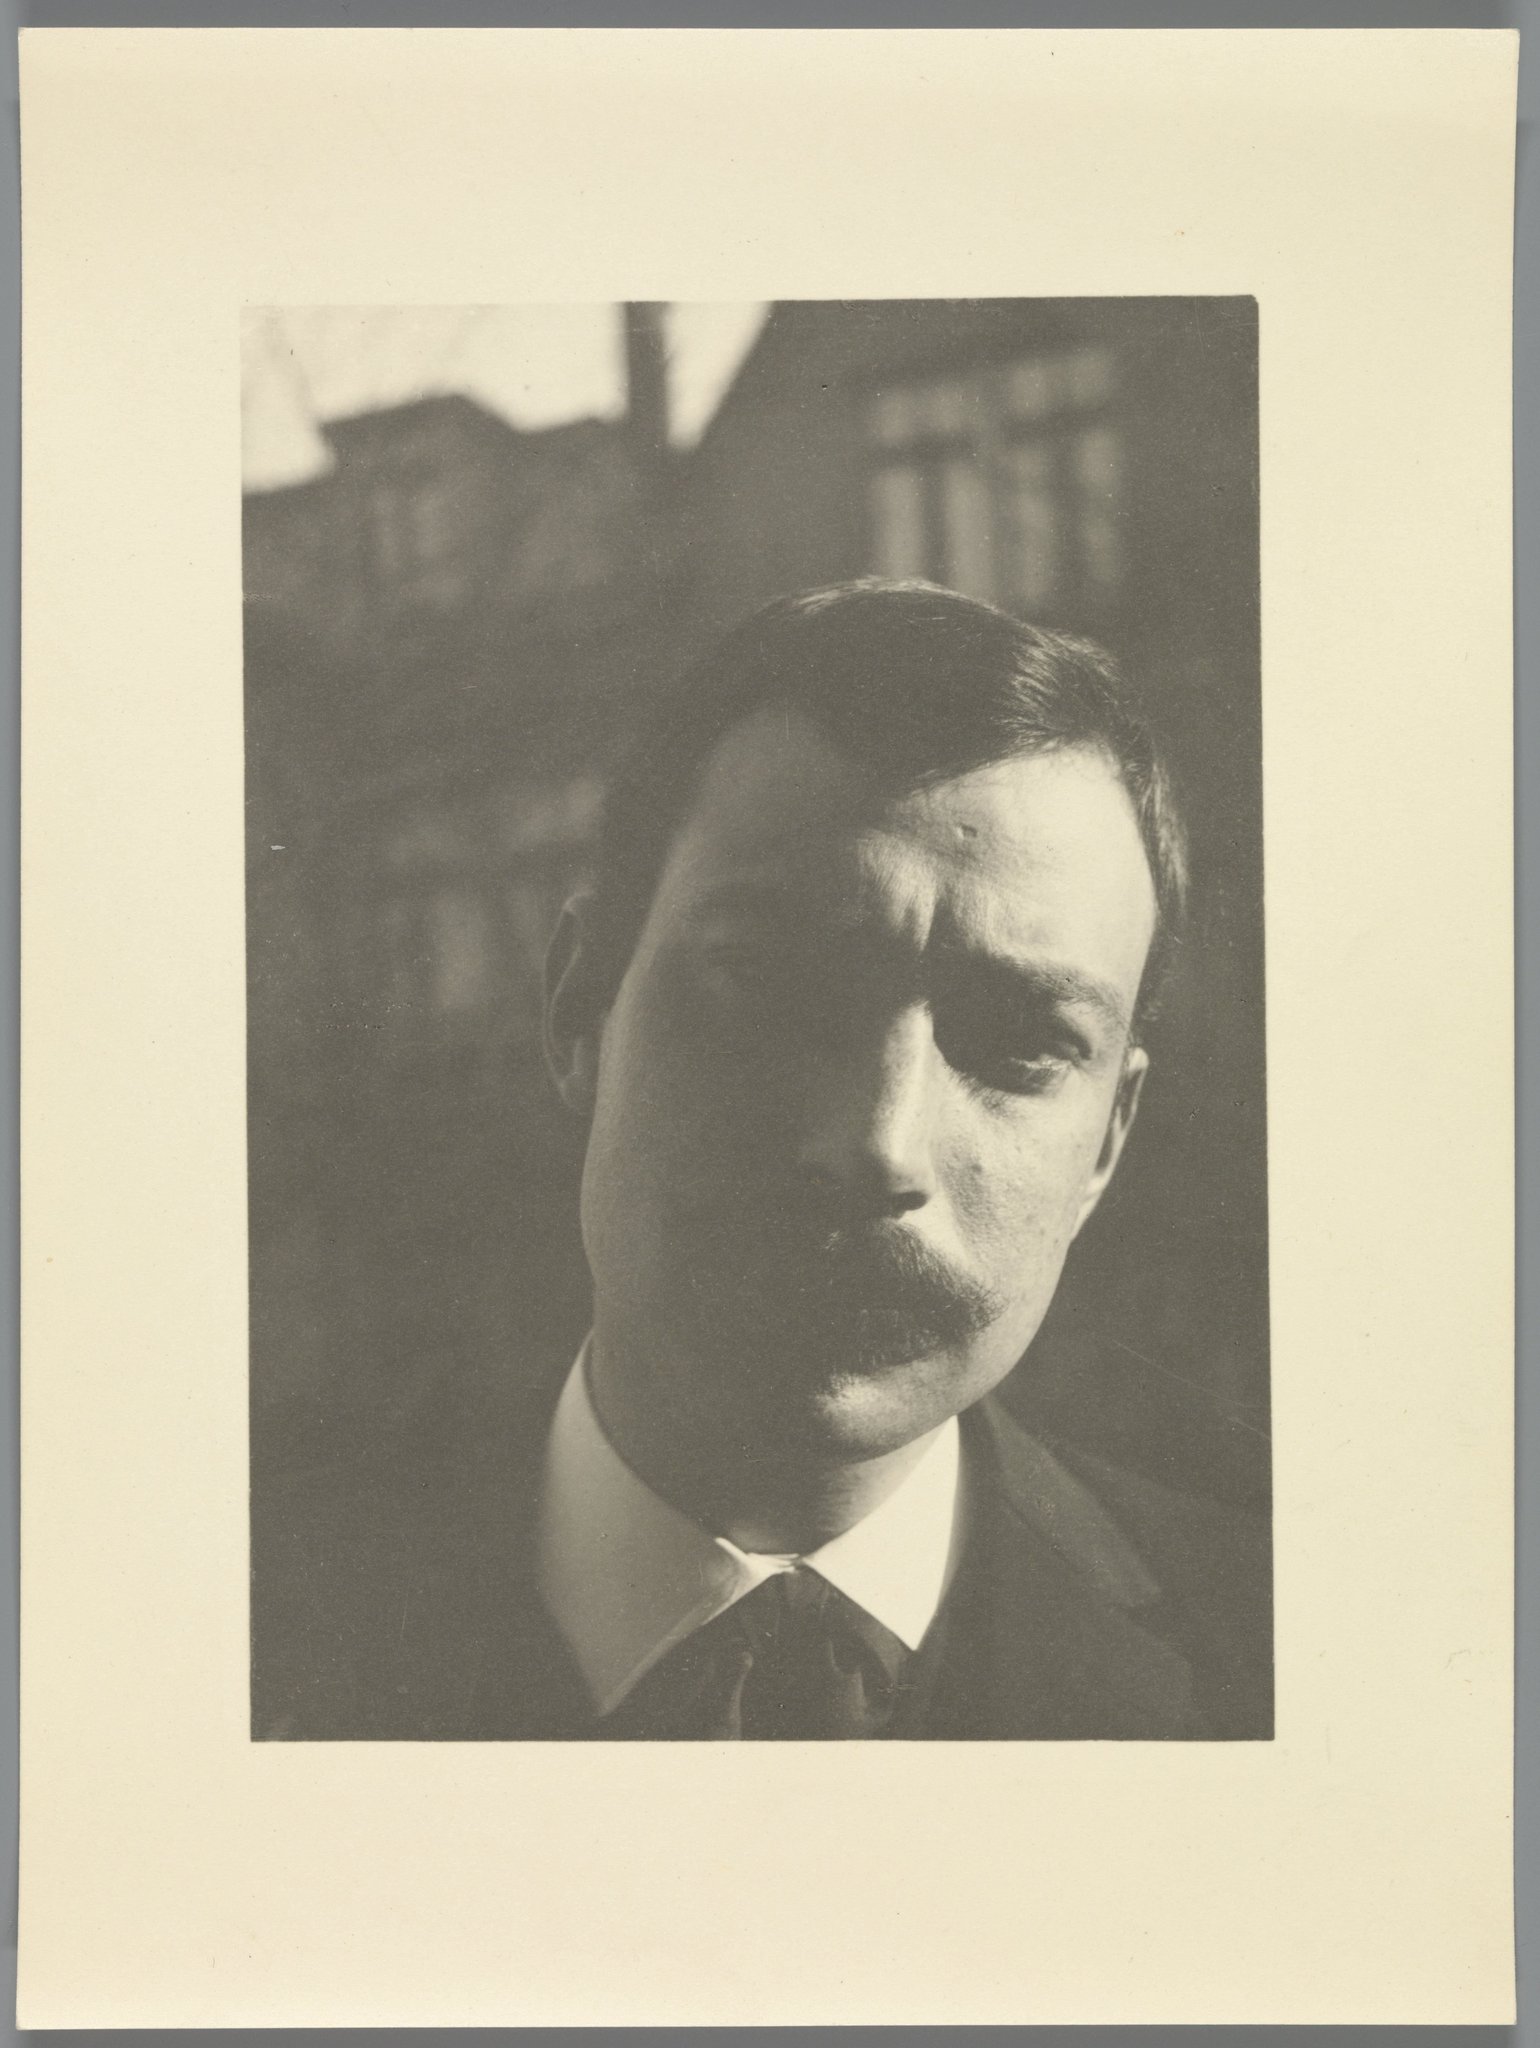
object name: photograph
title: Reproductie naar een foto van Willem Witsen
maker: Anonymous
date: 1860-1915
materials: paper, photographic support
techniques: gelatin silver print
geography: netherlands